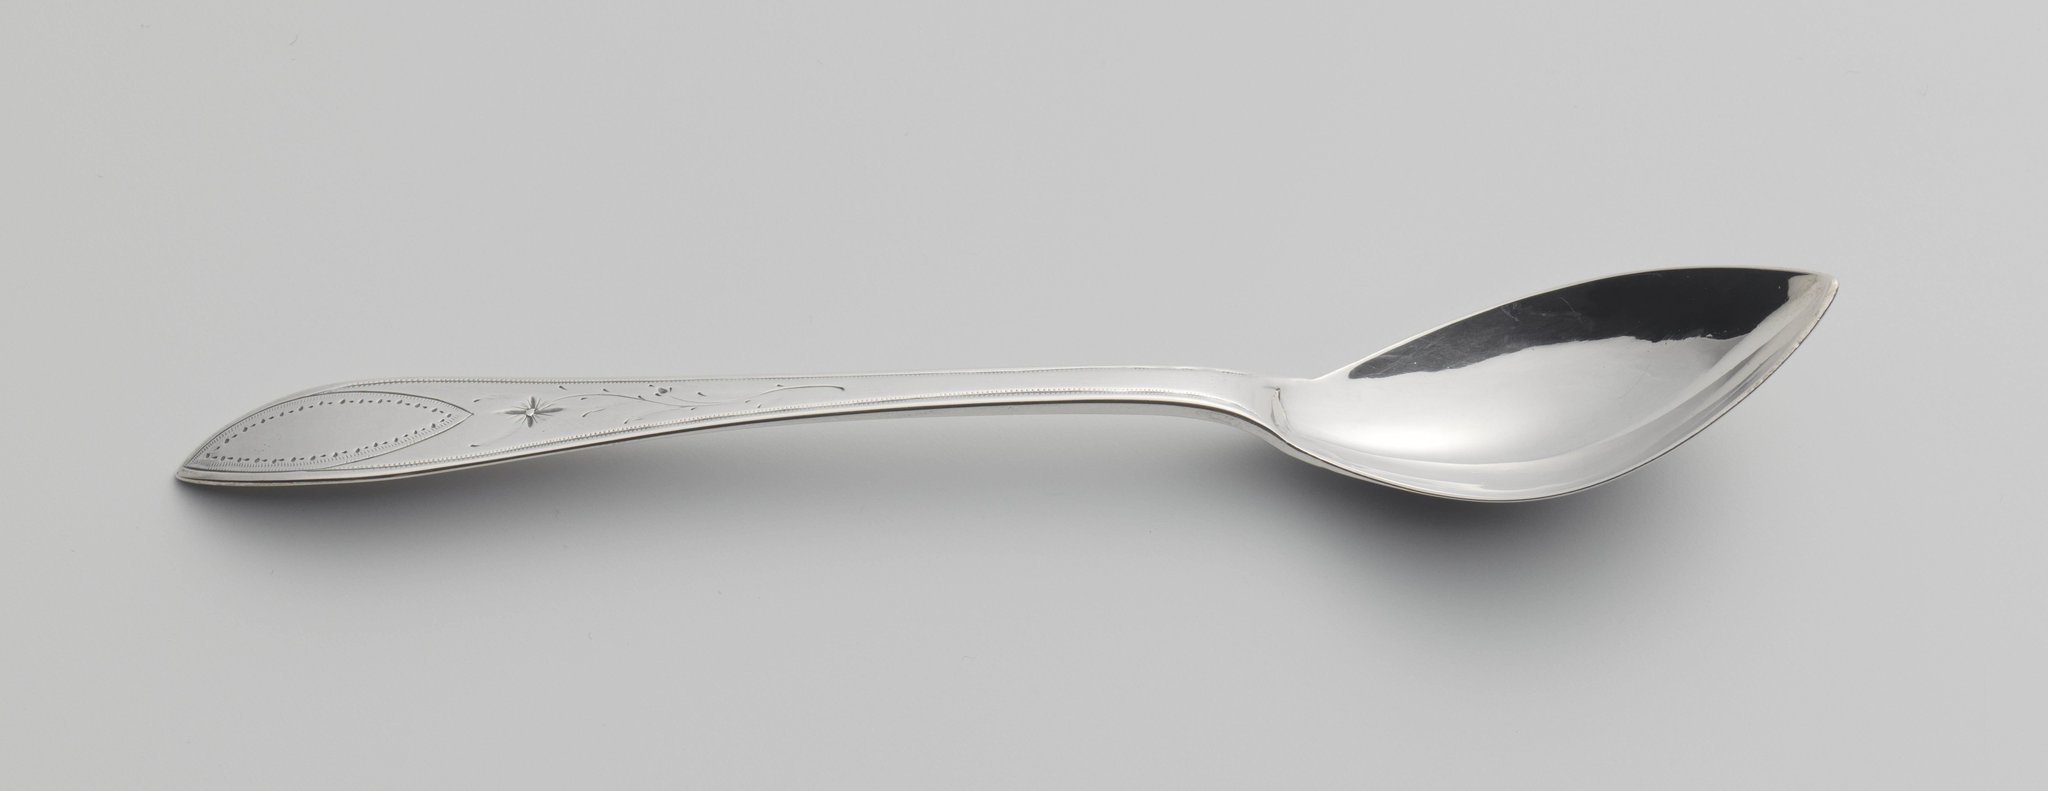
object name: teaspoon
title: Lepel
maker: cornelis knuysting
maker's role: silversmith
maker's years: 1730-1812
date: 1802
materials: silver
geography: rotterdam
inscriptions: mark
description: Lepel van zilver, met spits ovale bak en spits toelopende steel. De steel is aan de bovenzijde gegraveerd met een bloemrank en een ovaal medaillon.